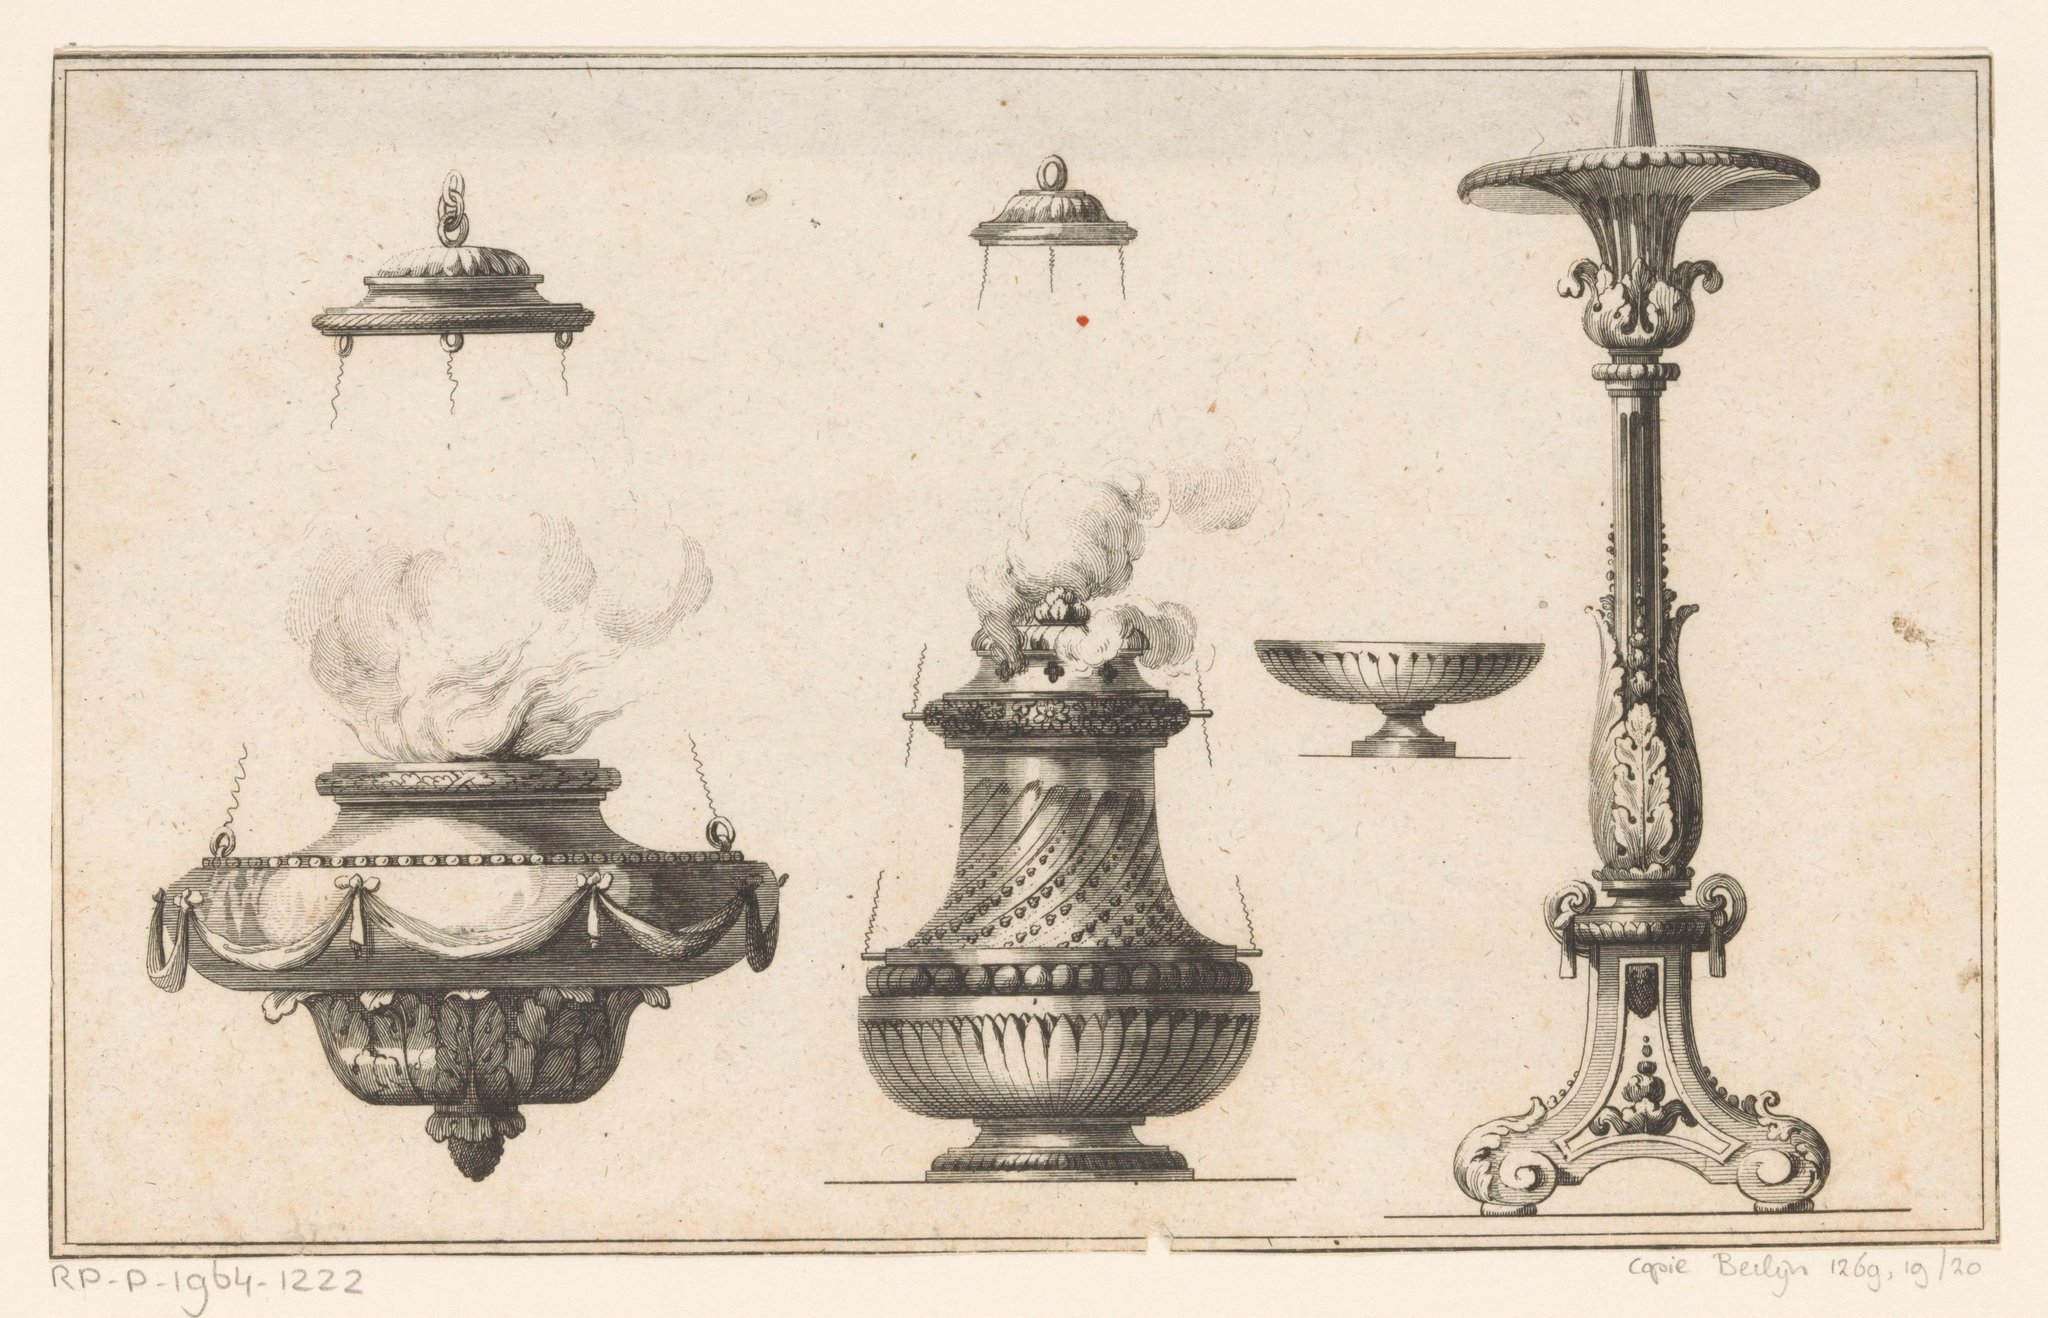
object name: print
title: Wierookvaten en kaarsenstandaard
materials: paper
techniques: engraving, etching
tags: chandelier, candelabrum, incense-burner ~ scents, perfumes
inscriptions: collector's mark: Lugt 2760, collector's mark: Lugt 2228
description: Links en in het midden twee geornamenteerde wierookvaten. Rechts een hoge kaarsenstandaard met bladmotieven.